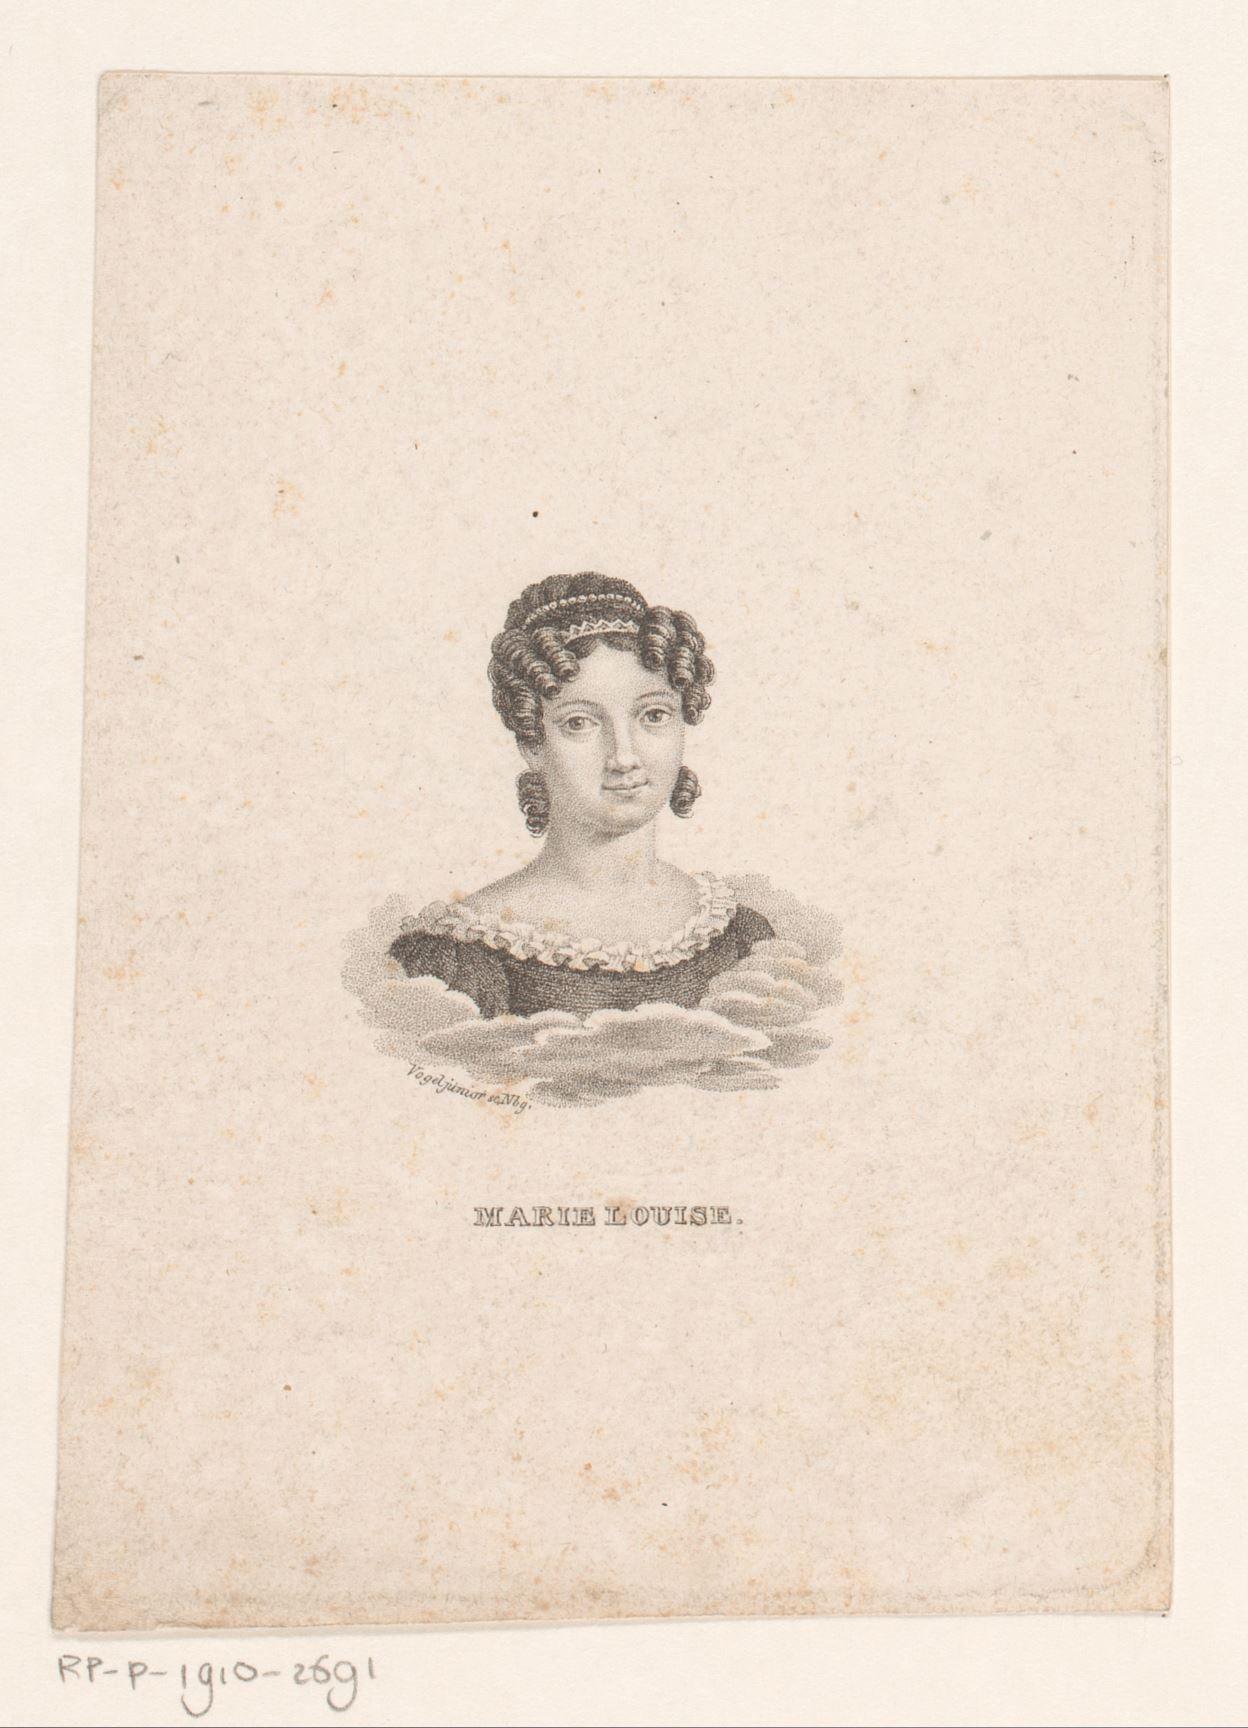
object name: print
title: Portret van Marie Louise van Oostenrijk, keizerin der Fransen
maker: georg friedrich vogel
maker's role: print maker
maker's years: 1798-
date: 1808-1834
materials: paper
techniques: etching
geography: nuremberg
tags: vienna, marie louise van oostenrijk (keizerin der fransen), historical persons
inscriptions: collector's mark: Lugt 2228